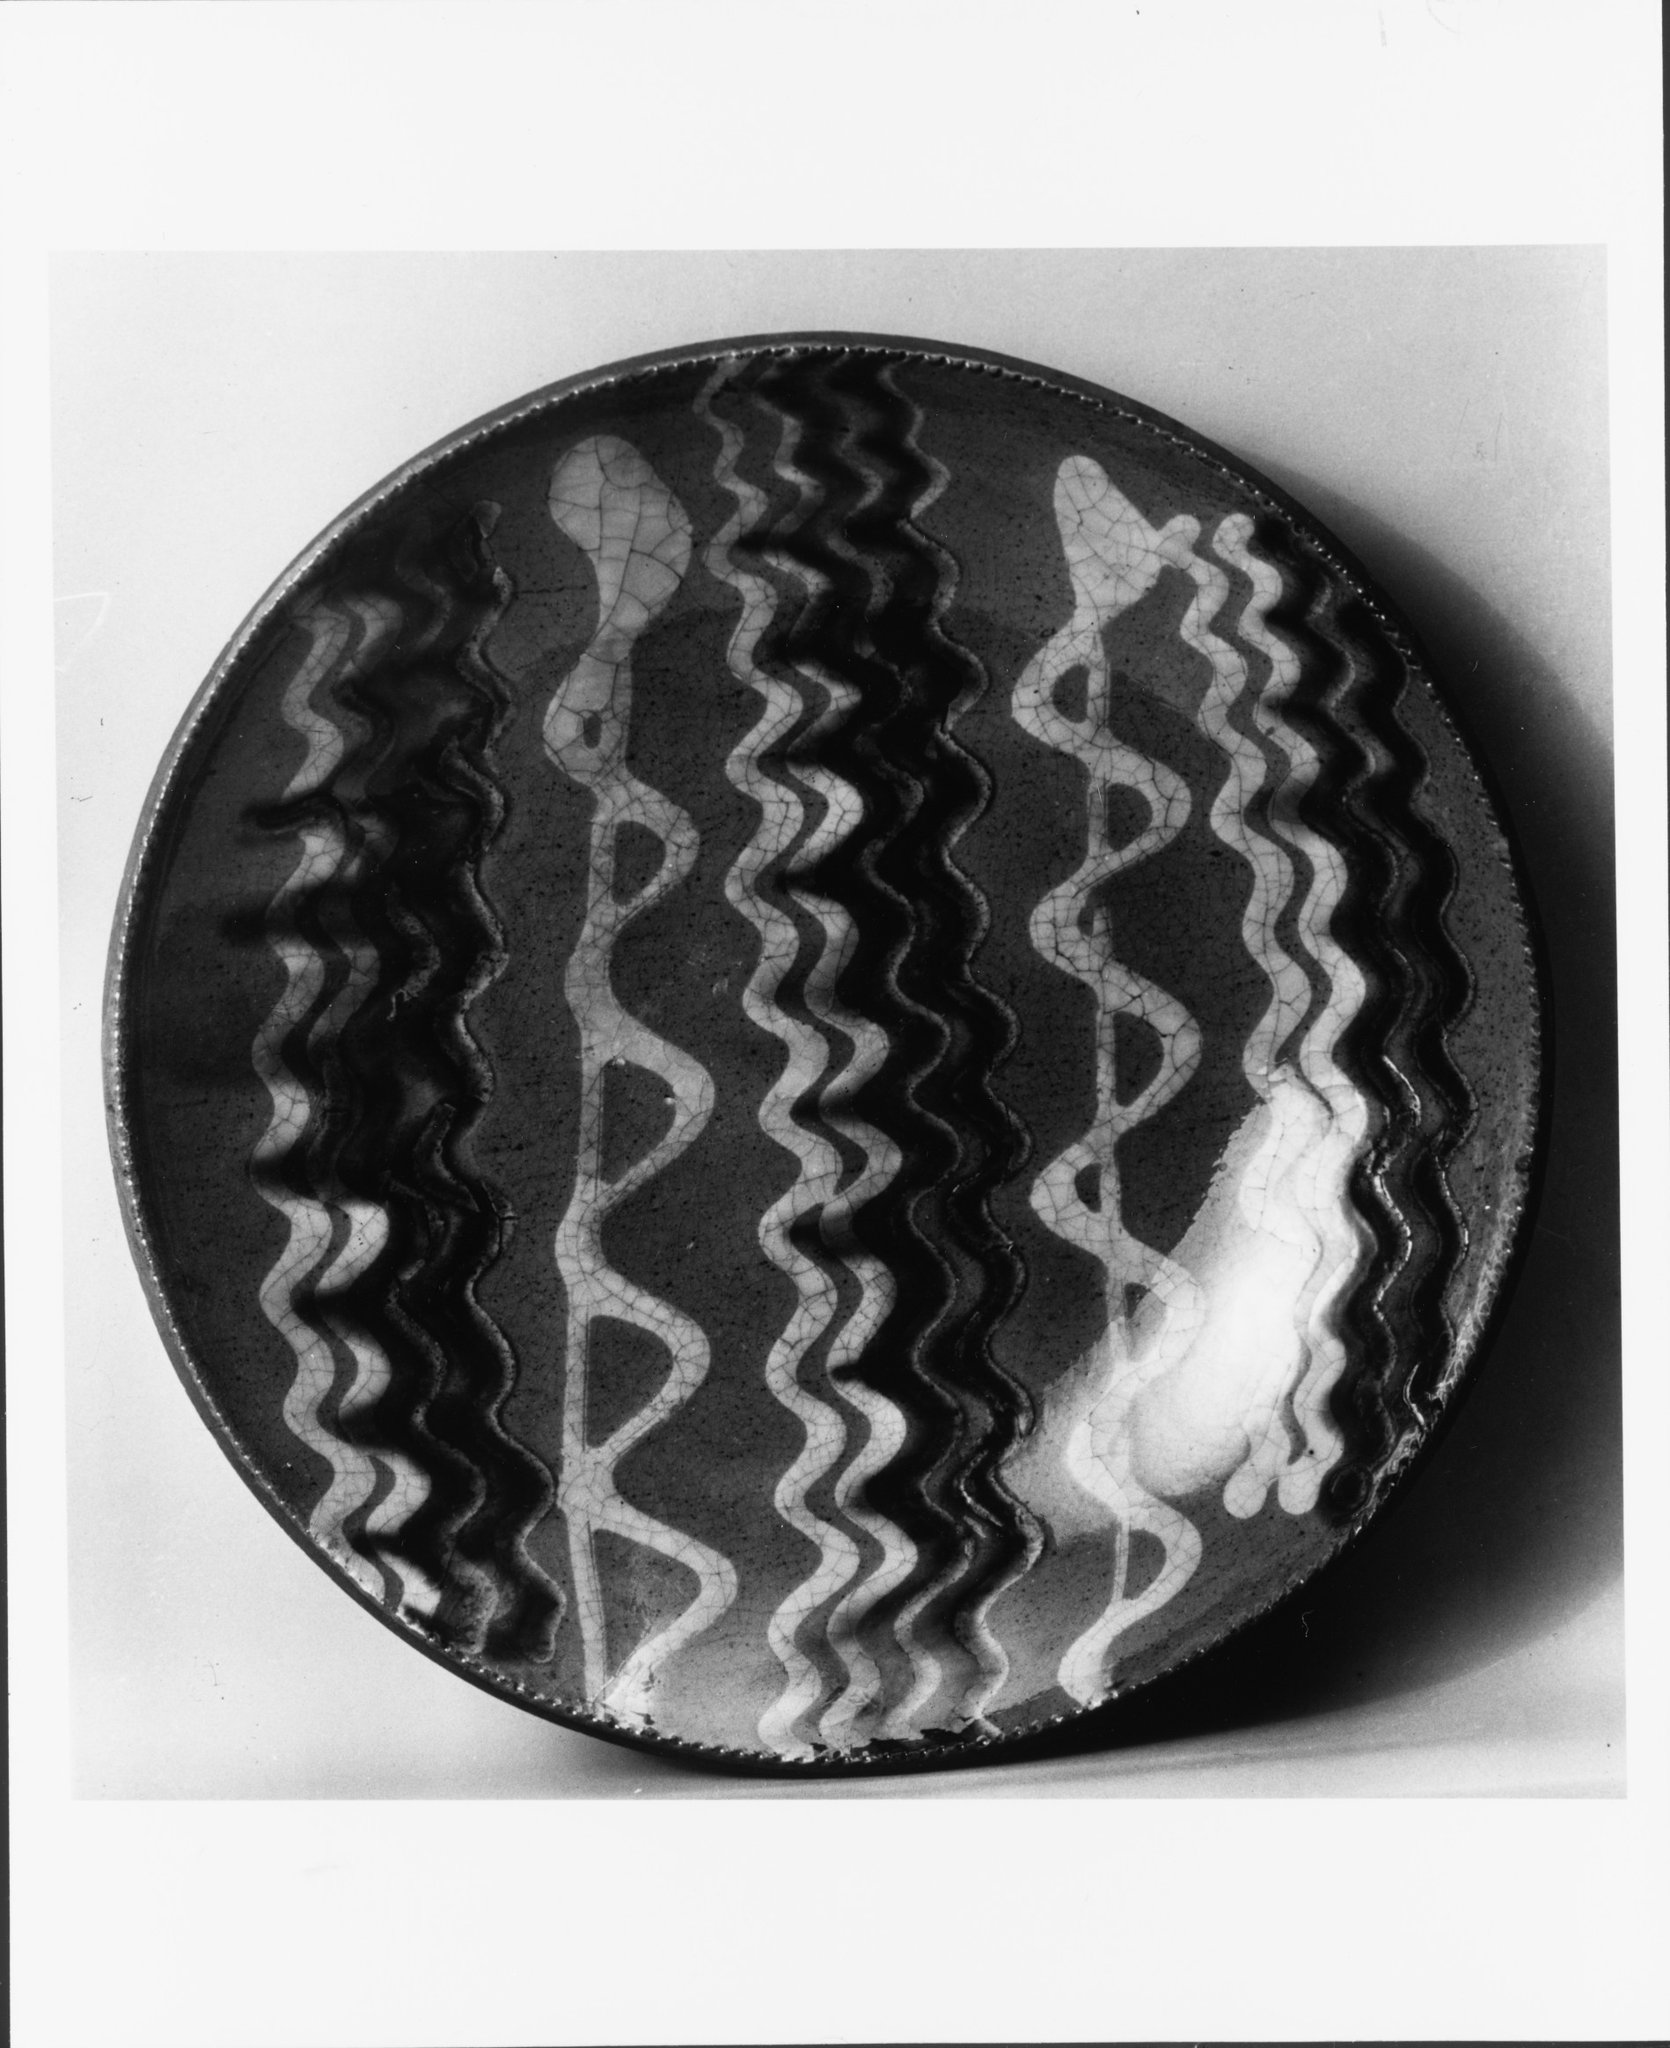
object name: plate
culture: american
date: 1800-1880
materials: earthenware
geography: united states